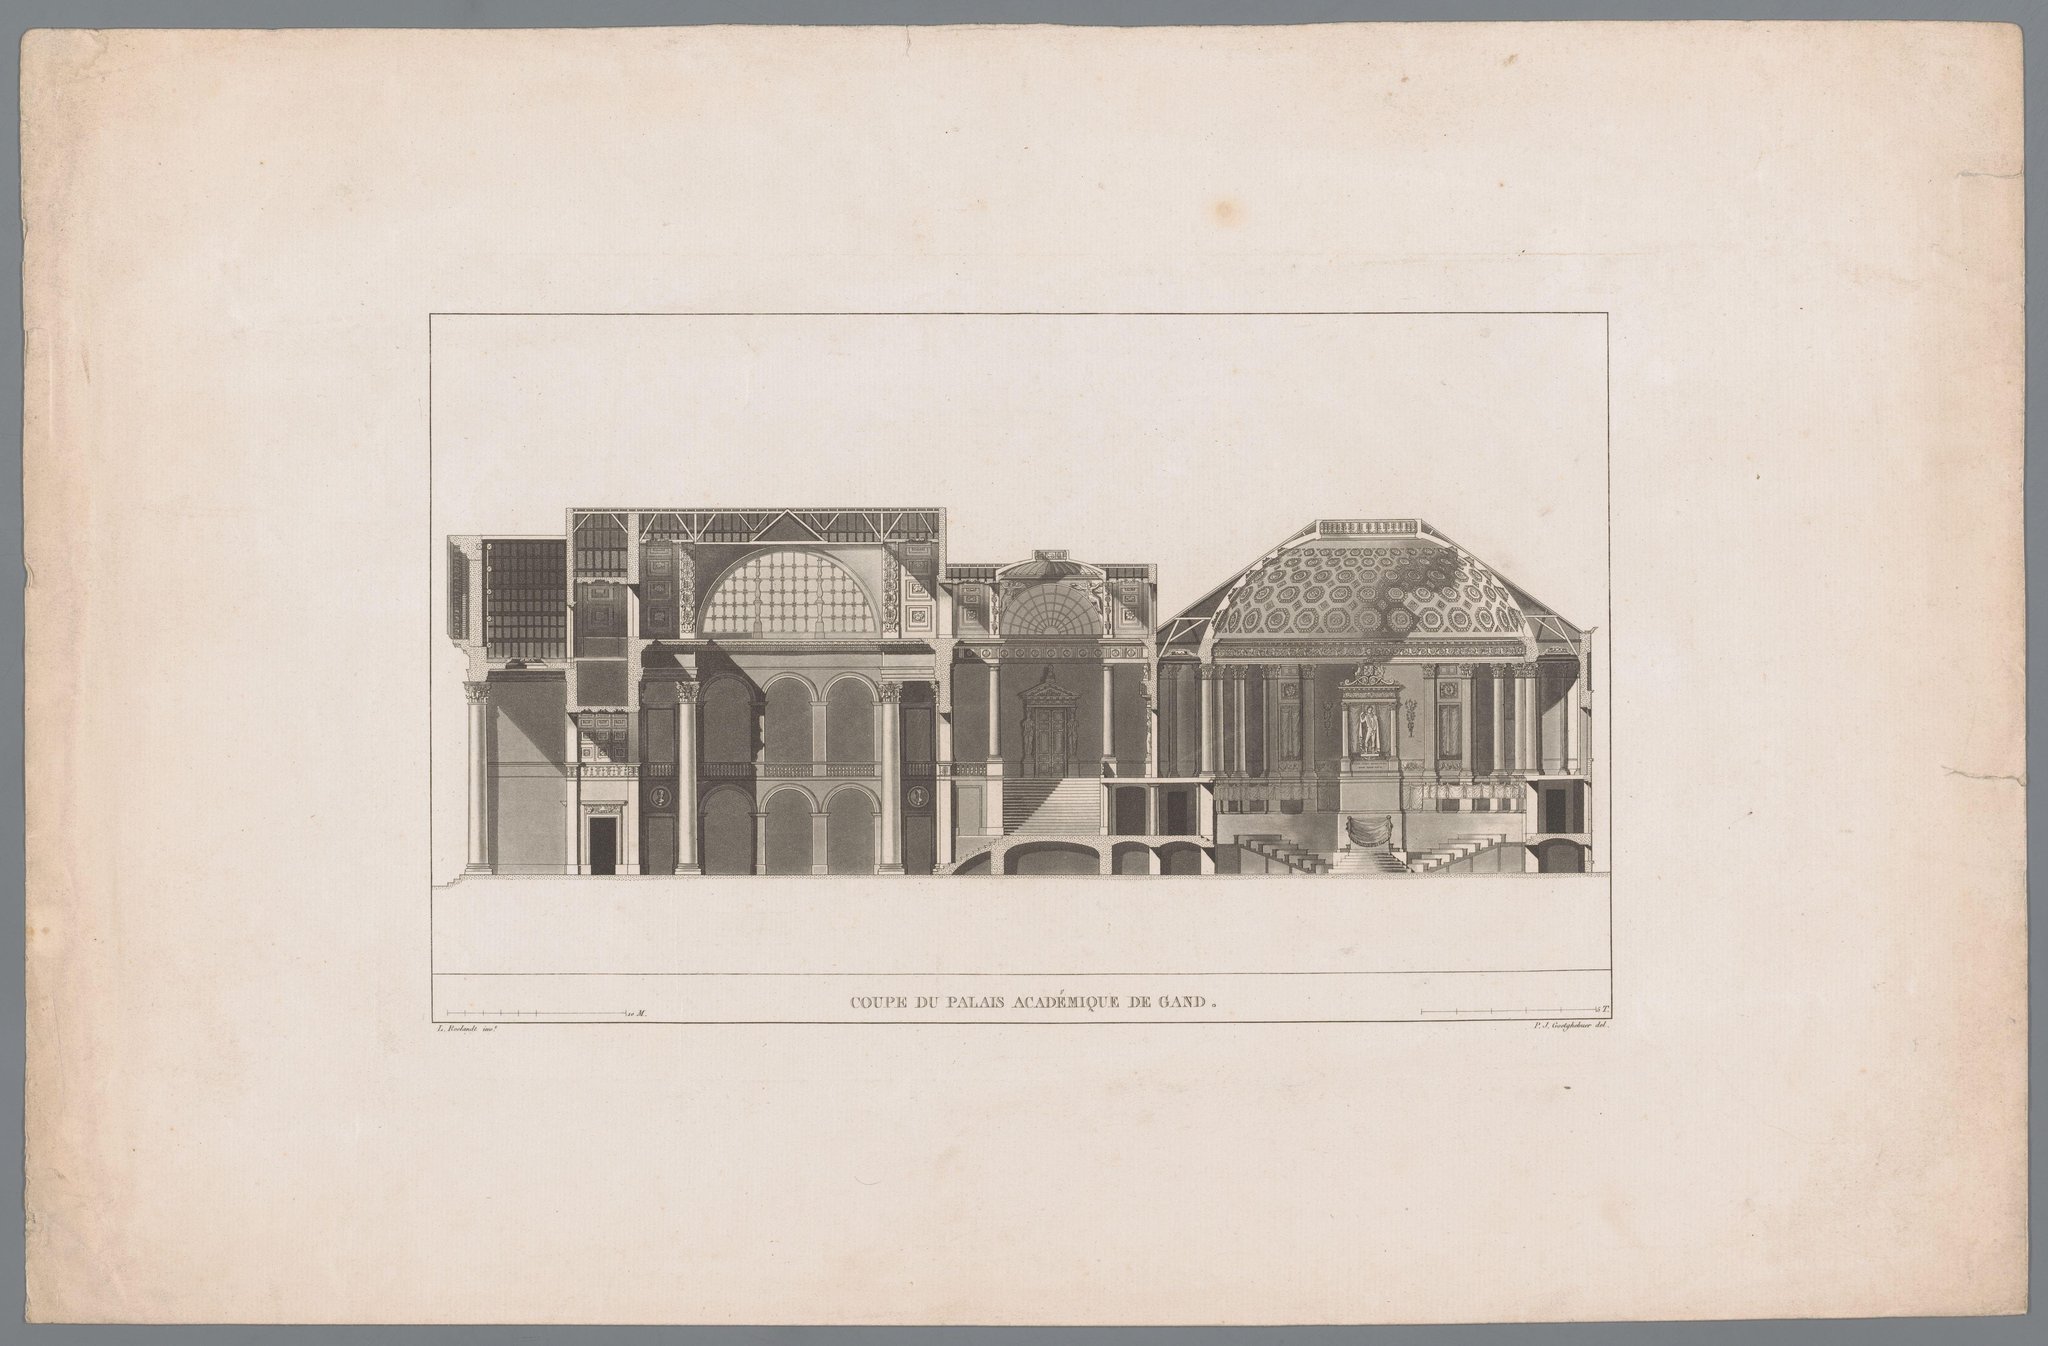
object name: print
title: Doorsnede van de Aula Academica in Gent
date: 1827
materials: paper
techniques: aquatint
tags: interior of the house, university, ghent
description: De eerdere staat van deze prent is gebruikt in: Goetghebuer, Pierre-Jacques. Choix des monuments, édifices et maisons les plus remarquables du royaume des Pays-Bas. Gent: André Benoît Steven, 1827. In het boek zijn de prenten nog niet voorzien van aquatint.